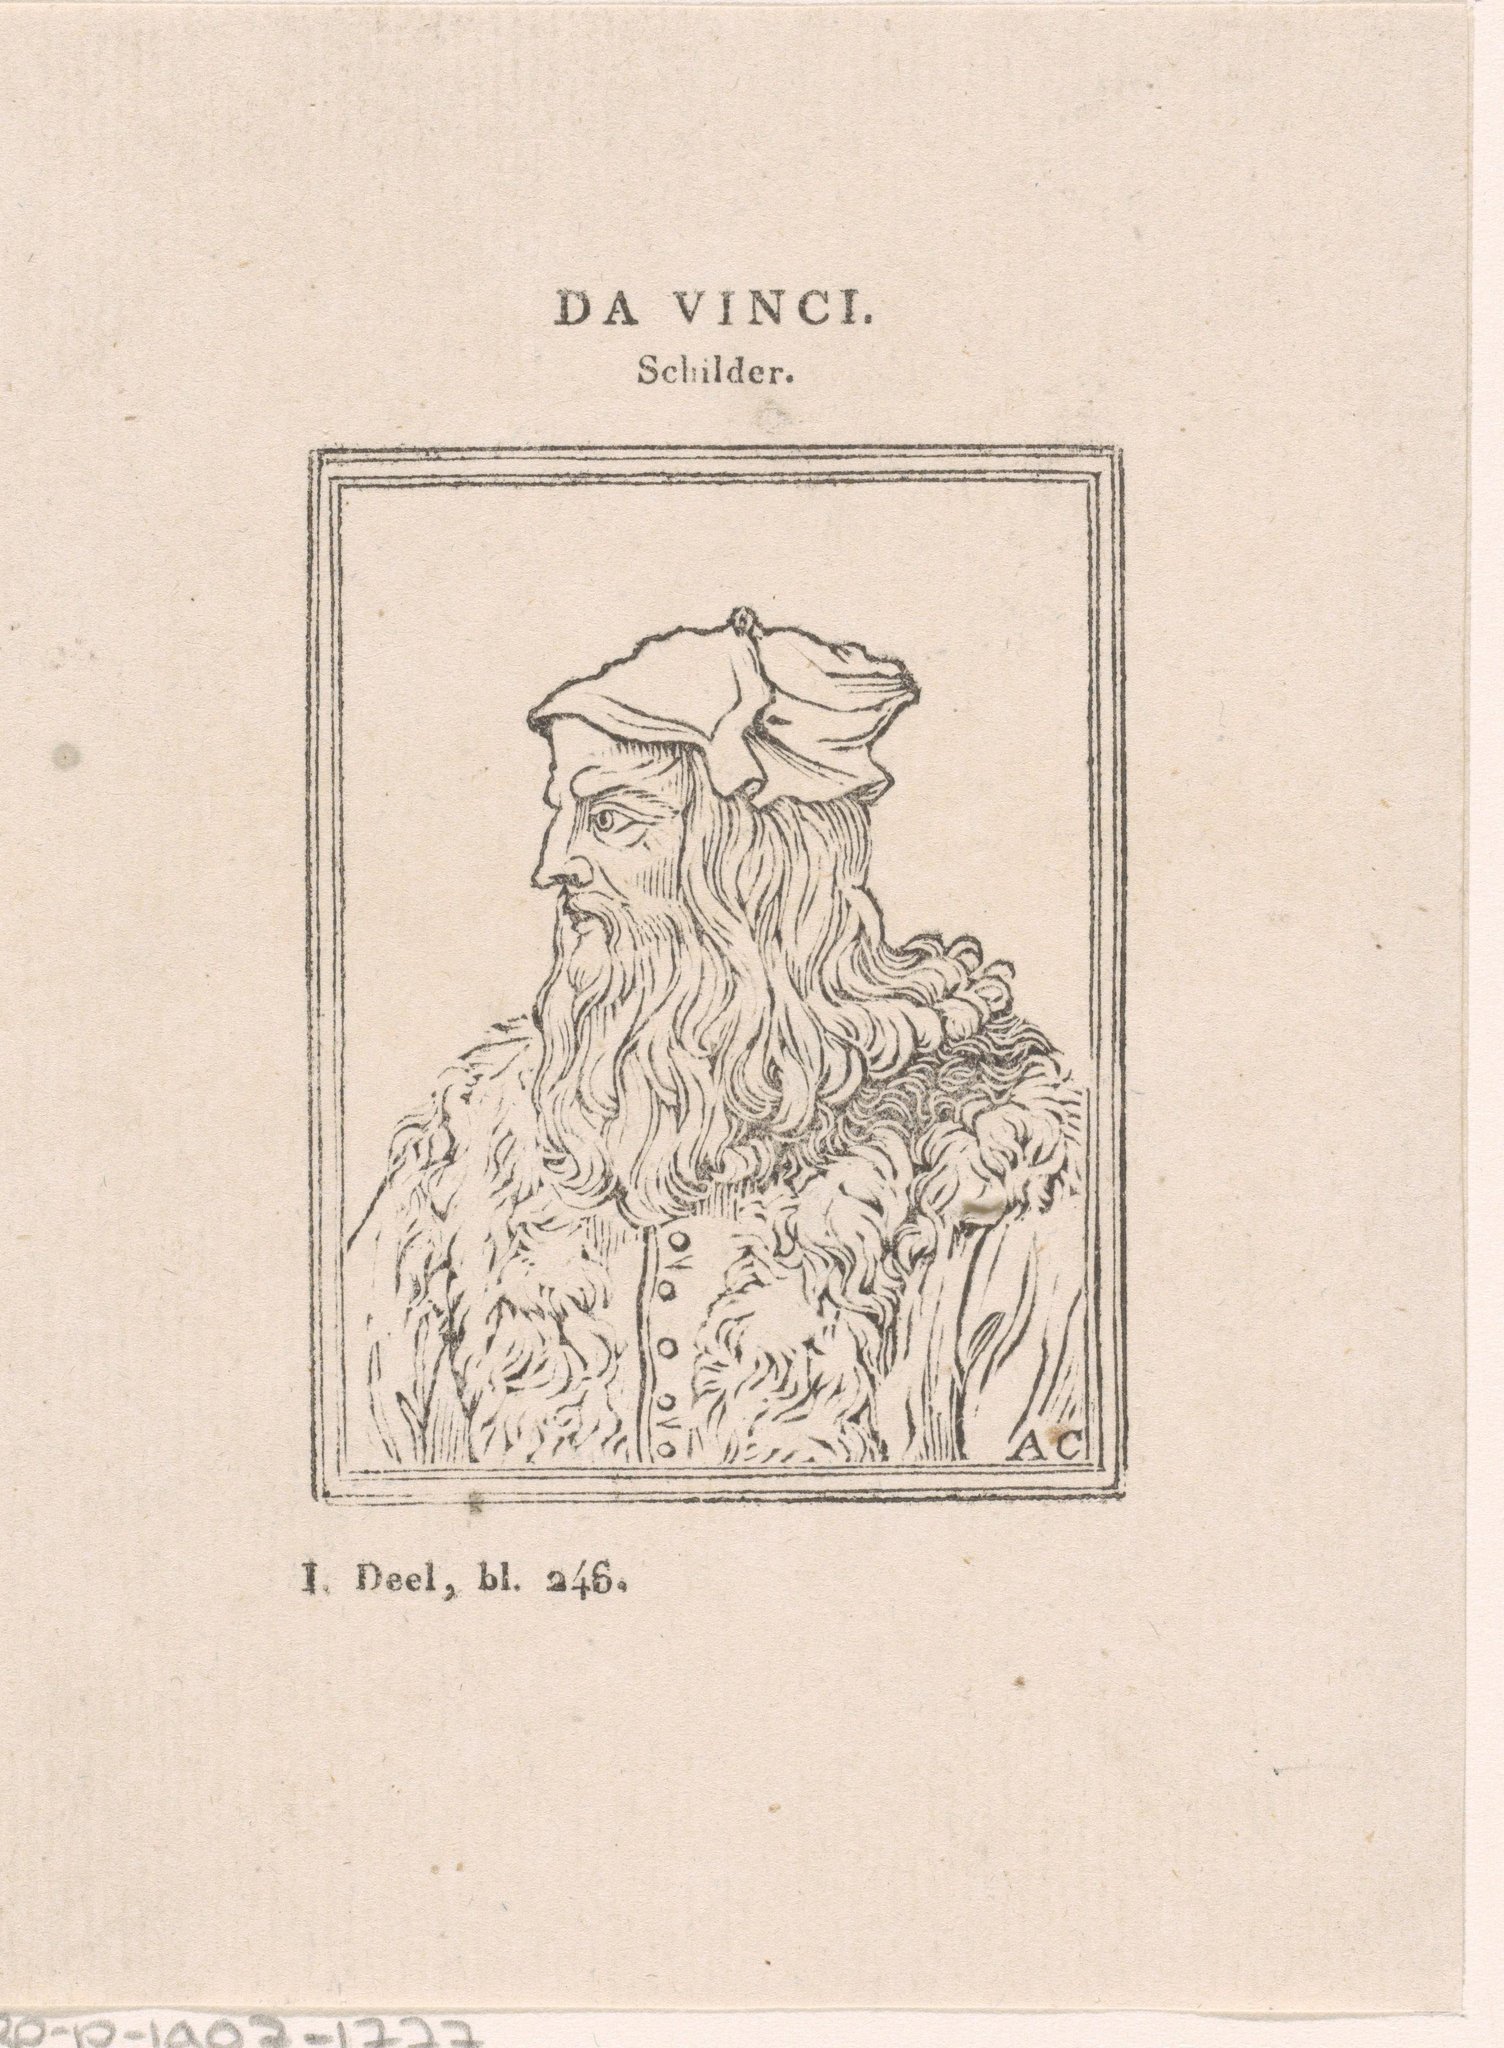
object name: print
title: Portret van Leonardo da Vinci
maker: monogrammist ac (16e eeuw)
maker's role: print maker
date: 1500-1599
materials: paper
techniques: letterpress printing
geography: netherlands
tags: artist, leonardo da vinci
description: Portret van Leonardo da Vinci. In de bovenmarge zijn naam en beroep.